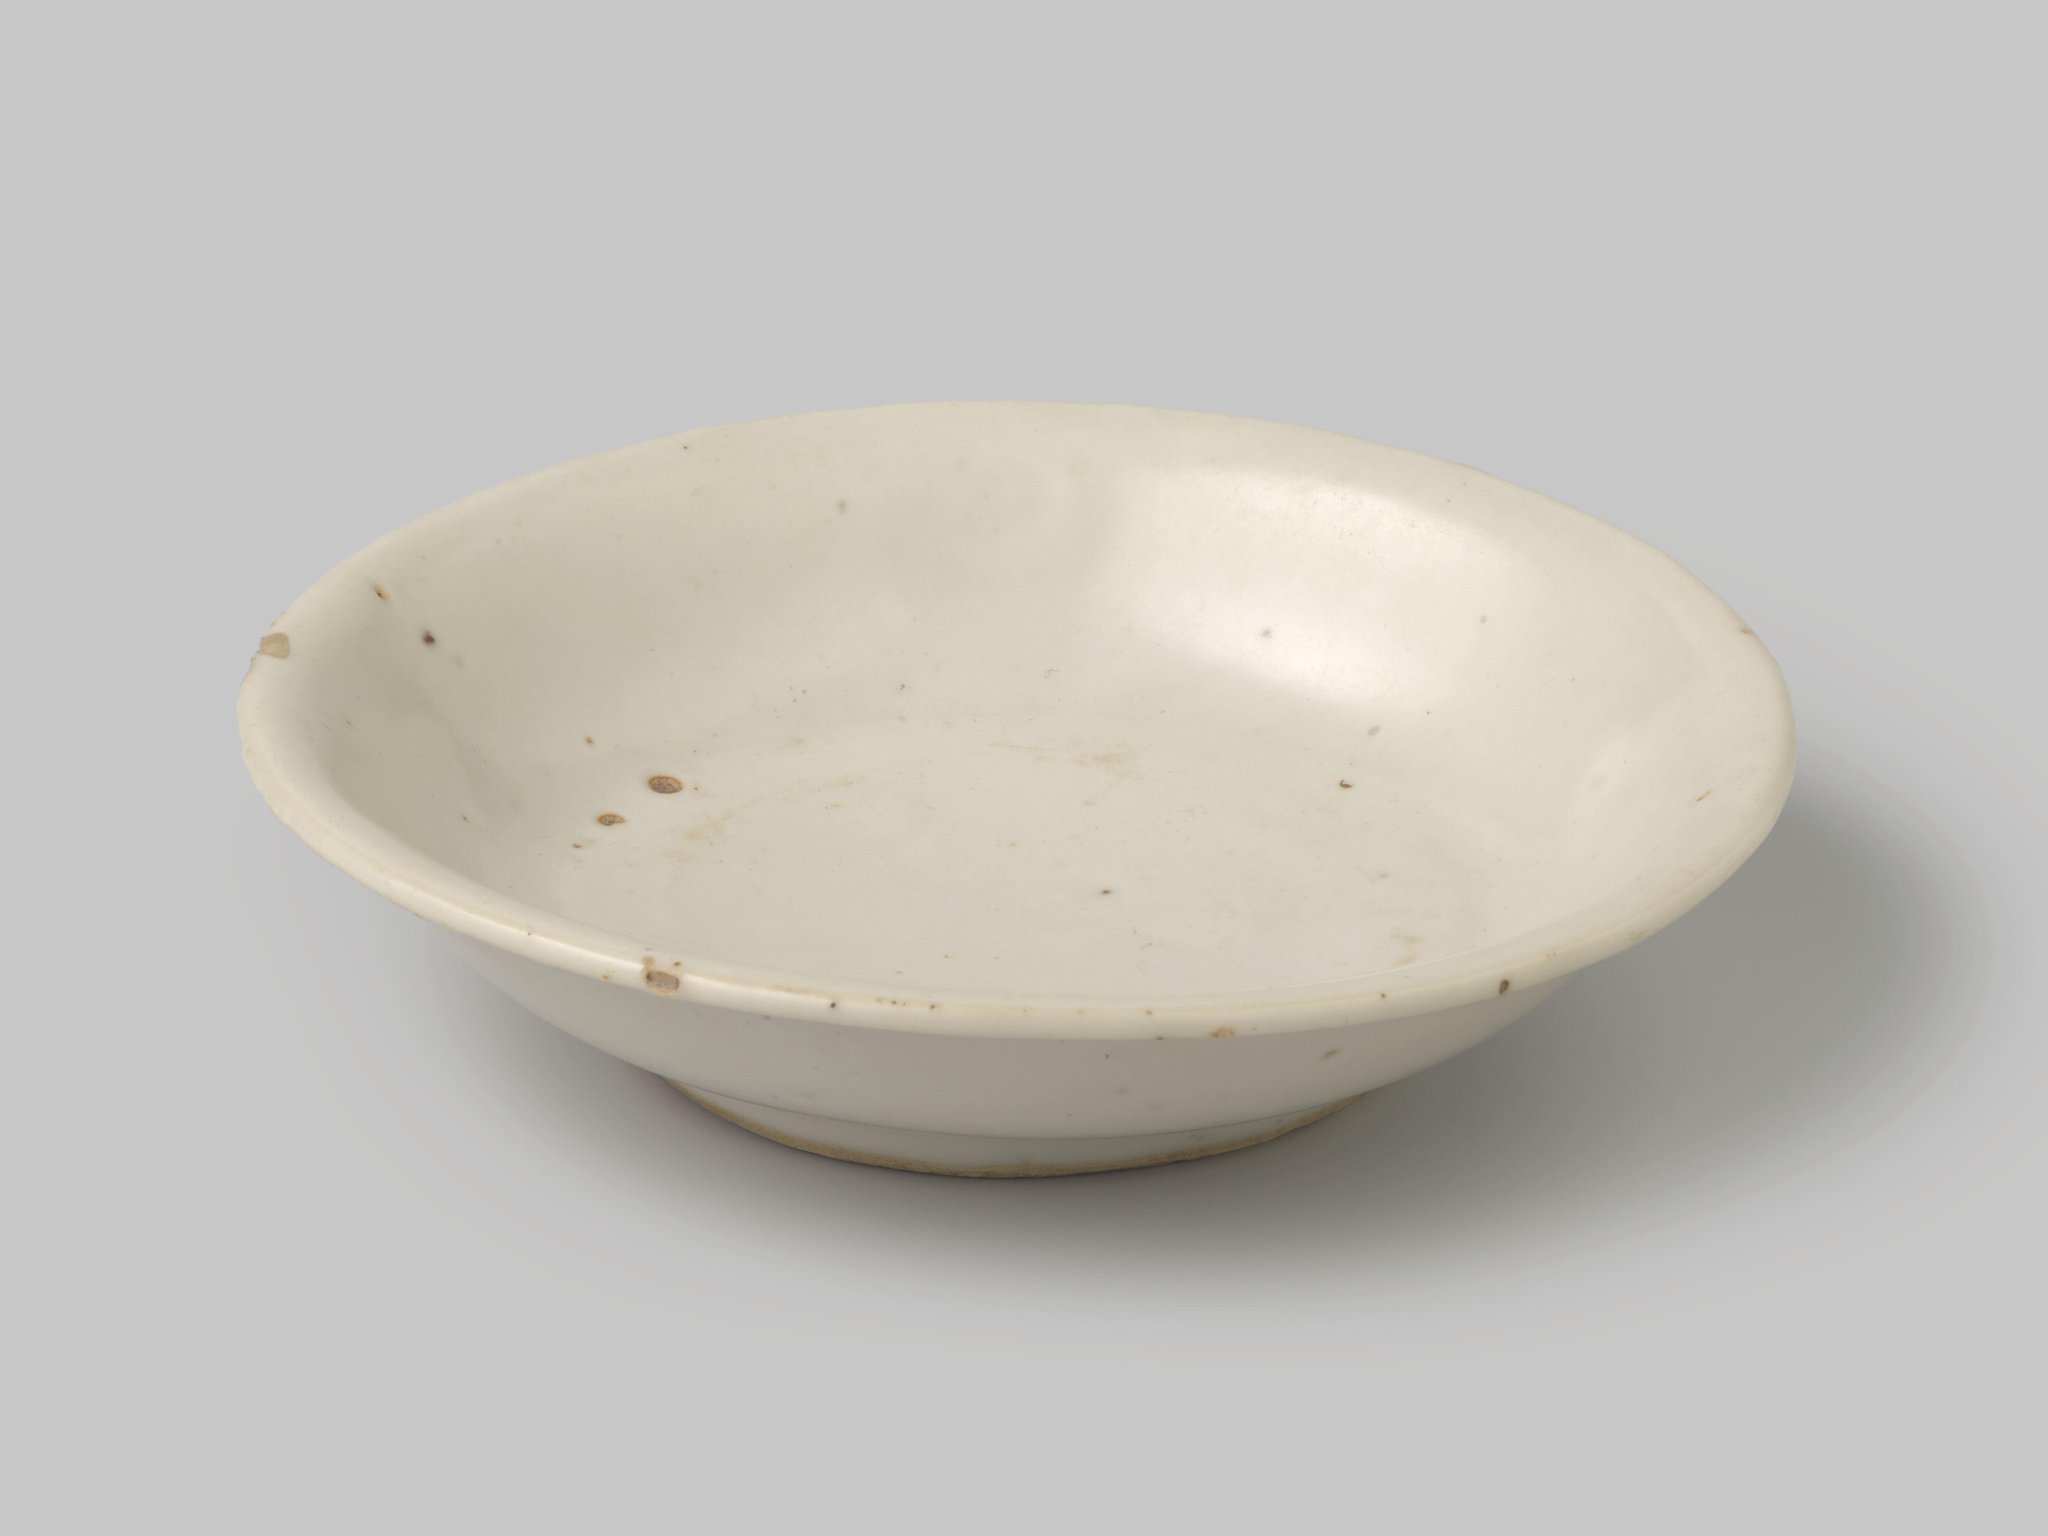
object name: plate dish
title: Saucer-dish with a translucent white glaze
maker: Anonymous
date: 1600-1699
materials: glaze, porcelain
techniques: firing, turning, vitrification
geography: china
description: Schaal van porselein, bedekt met een doorschijnend wit glazuur. Een chip in de rand.